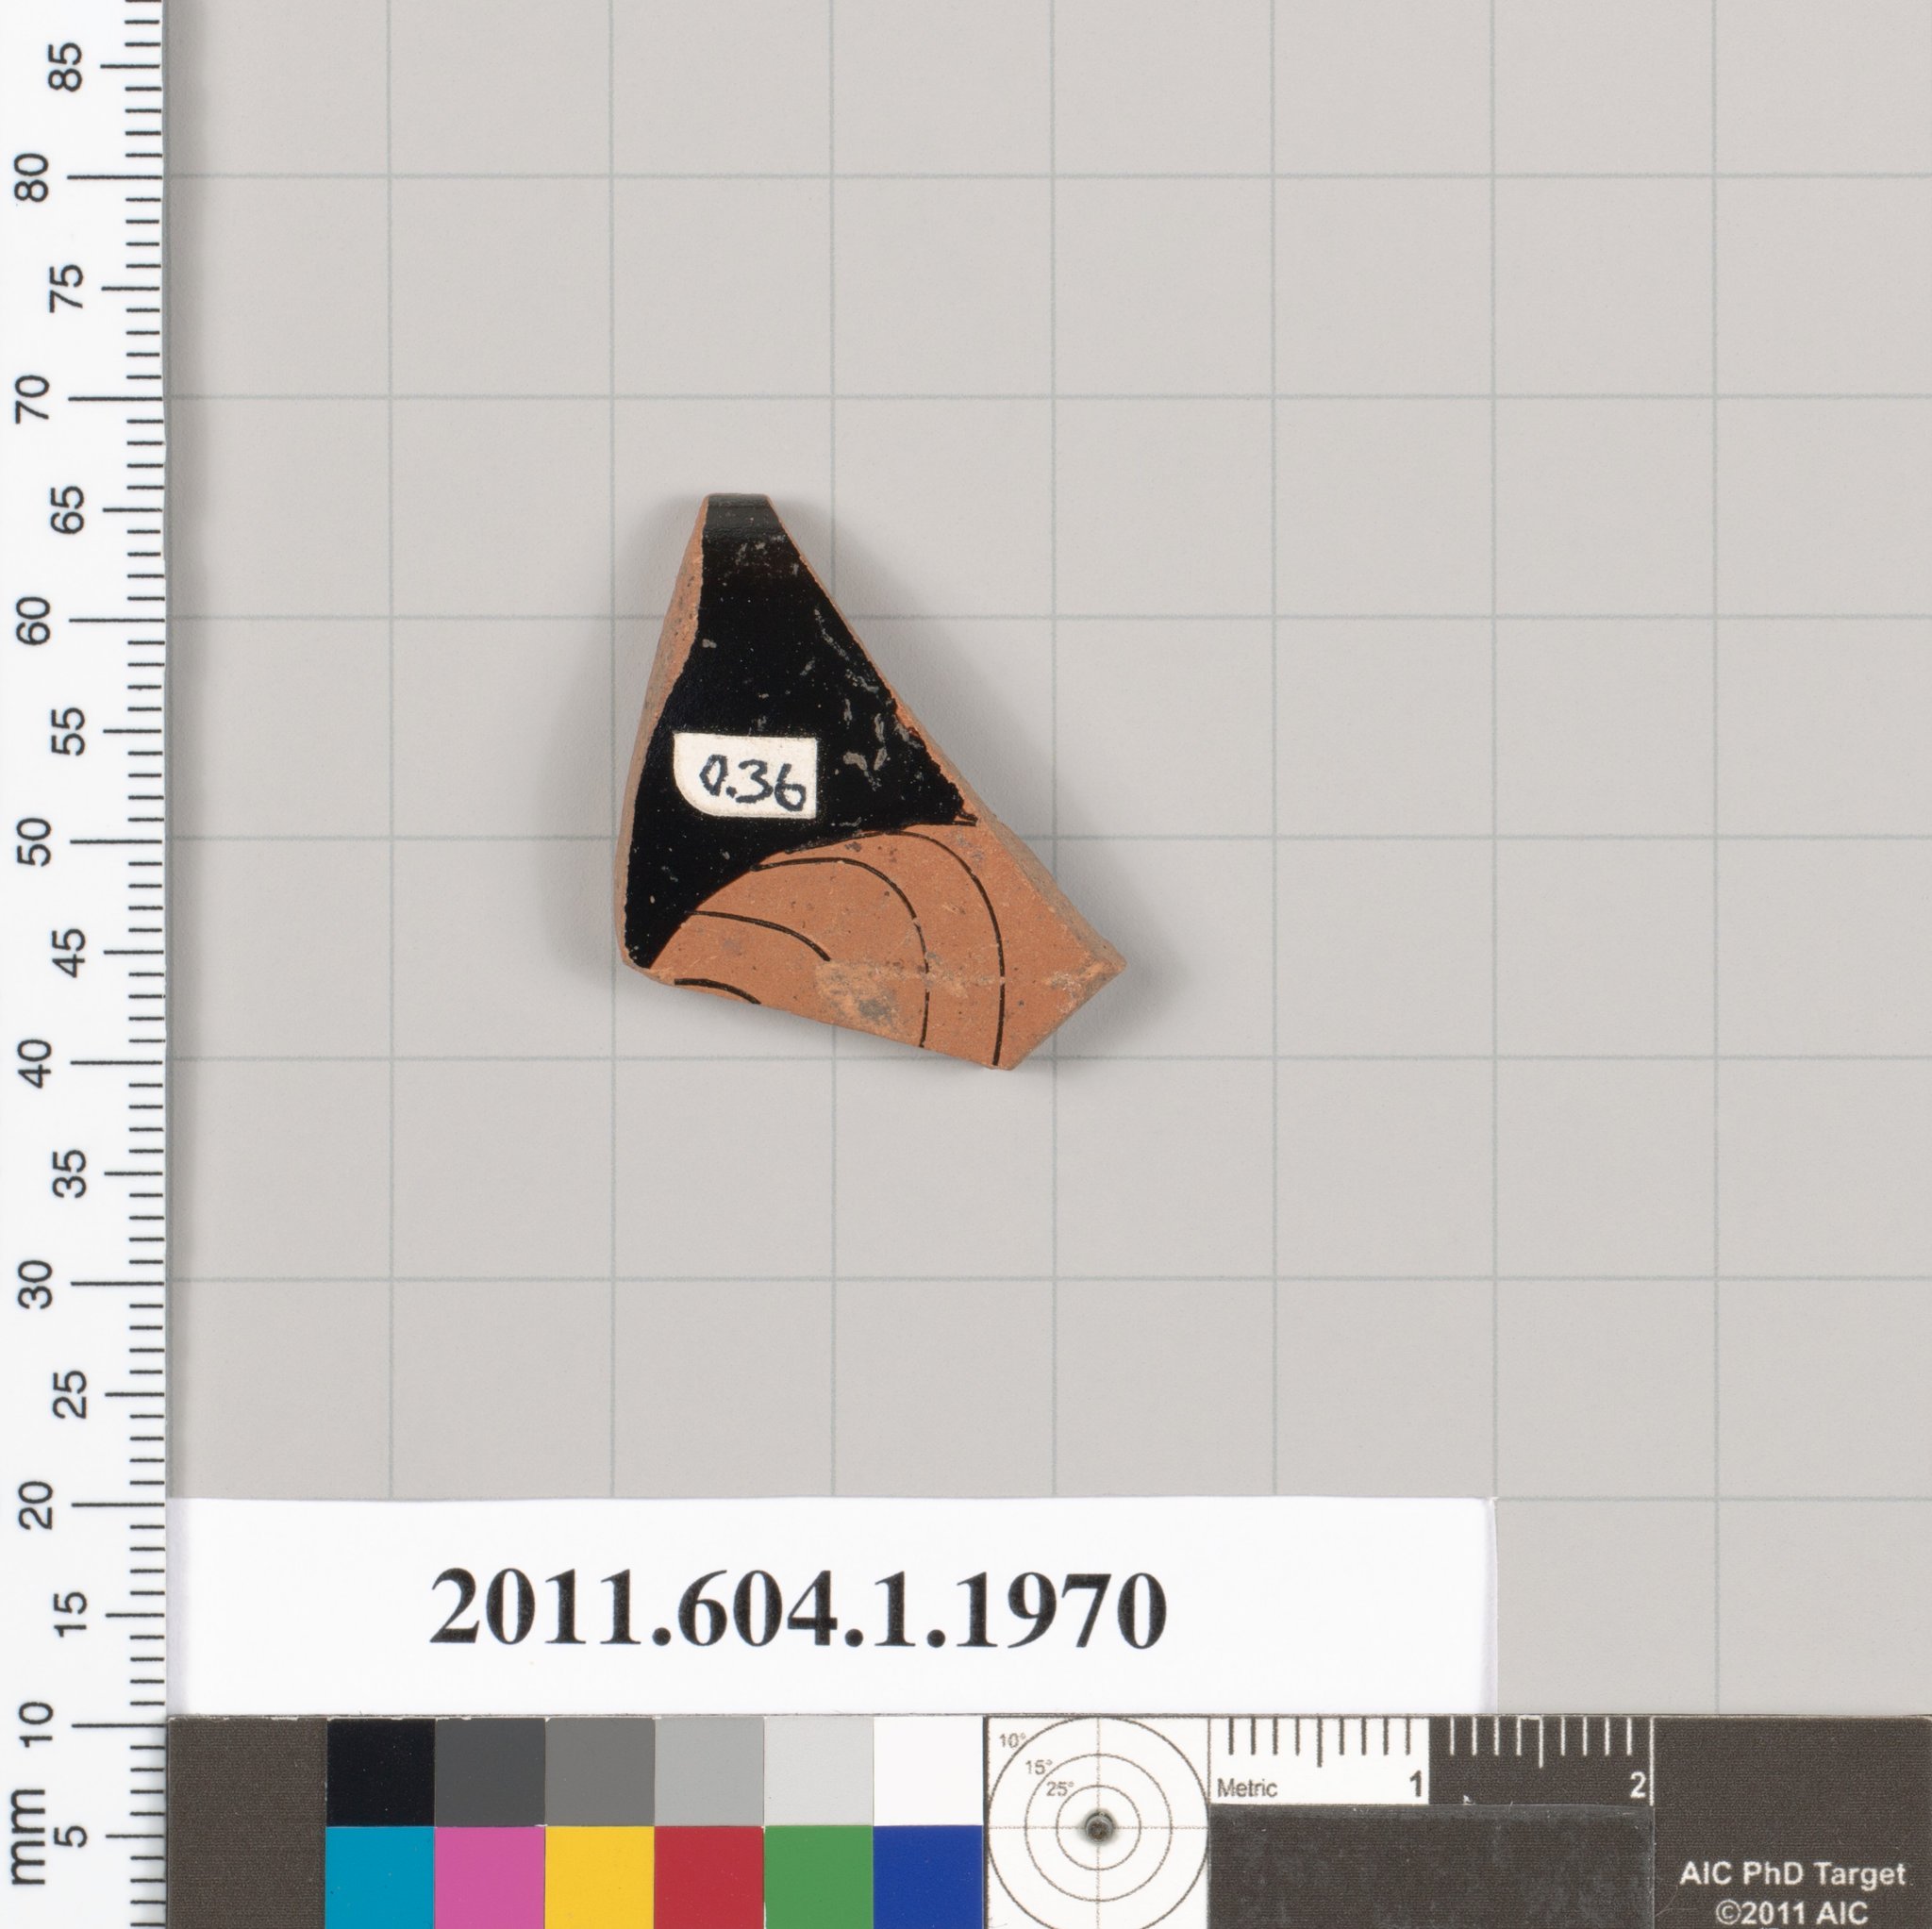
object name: kylix fragment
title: Terracotta rim fragment of a kylix (drinking cup)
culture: greek, attic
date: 475-451 BCE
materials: terracotta